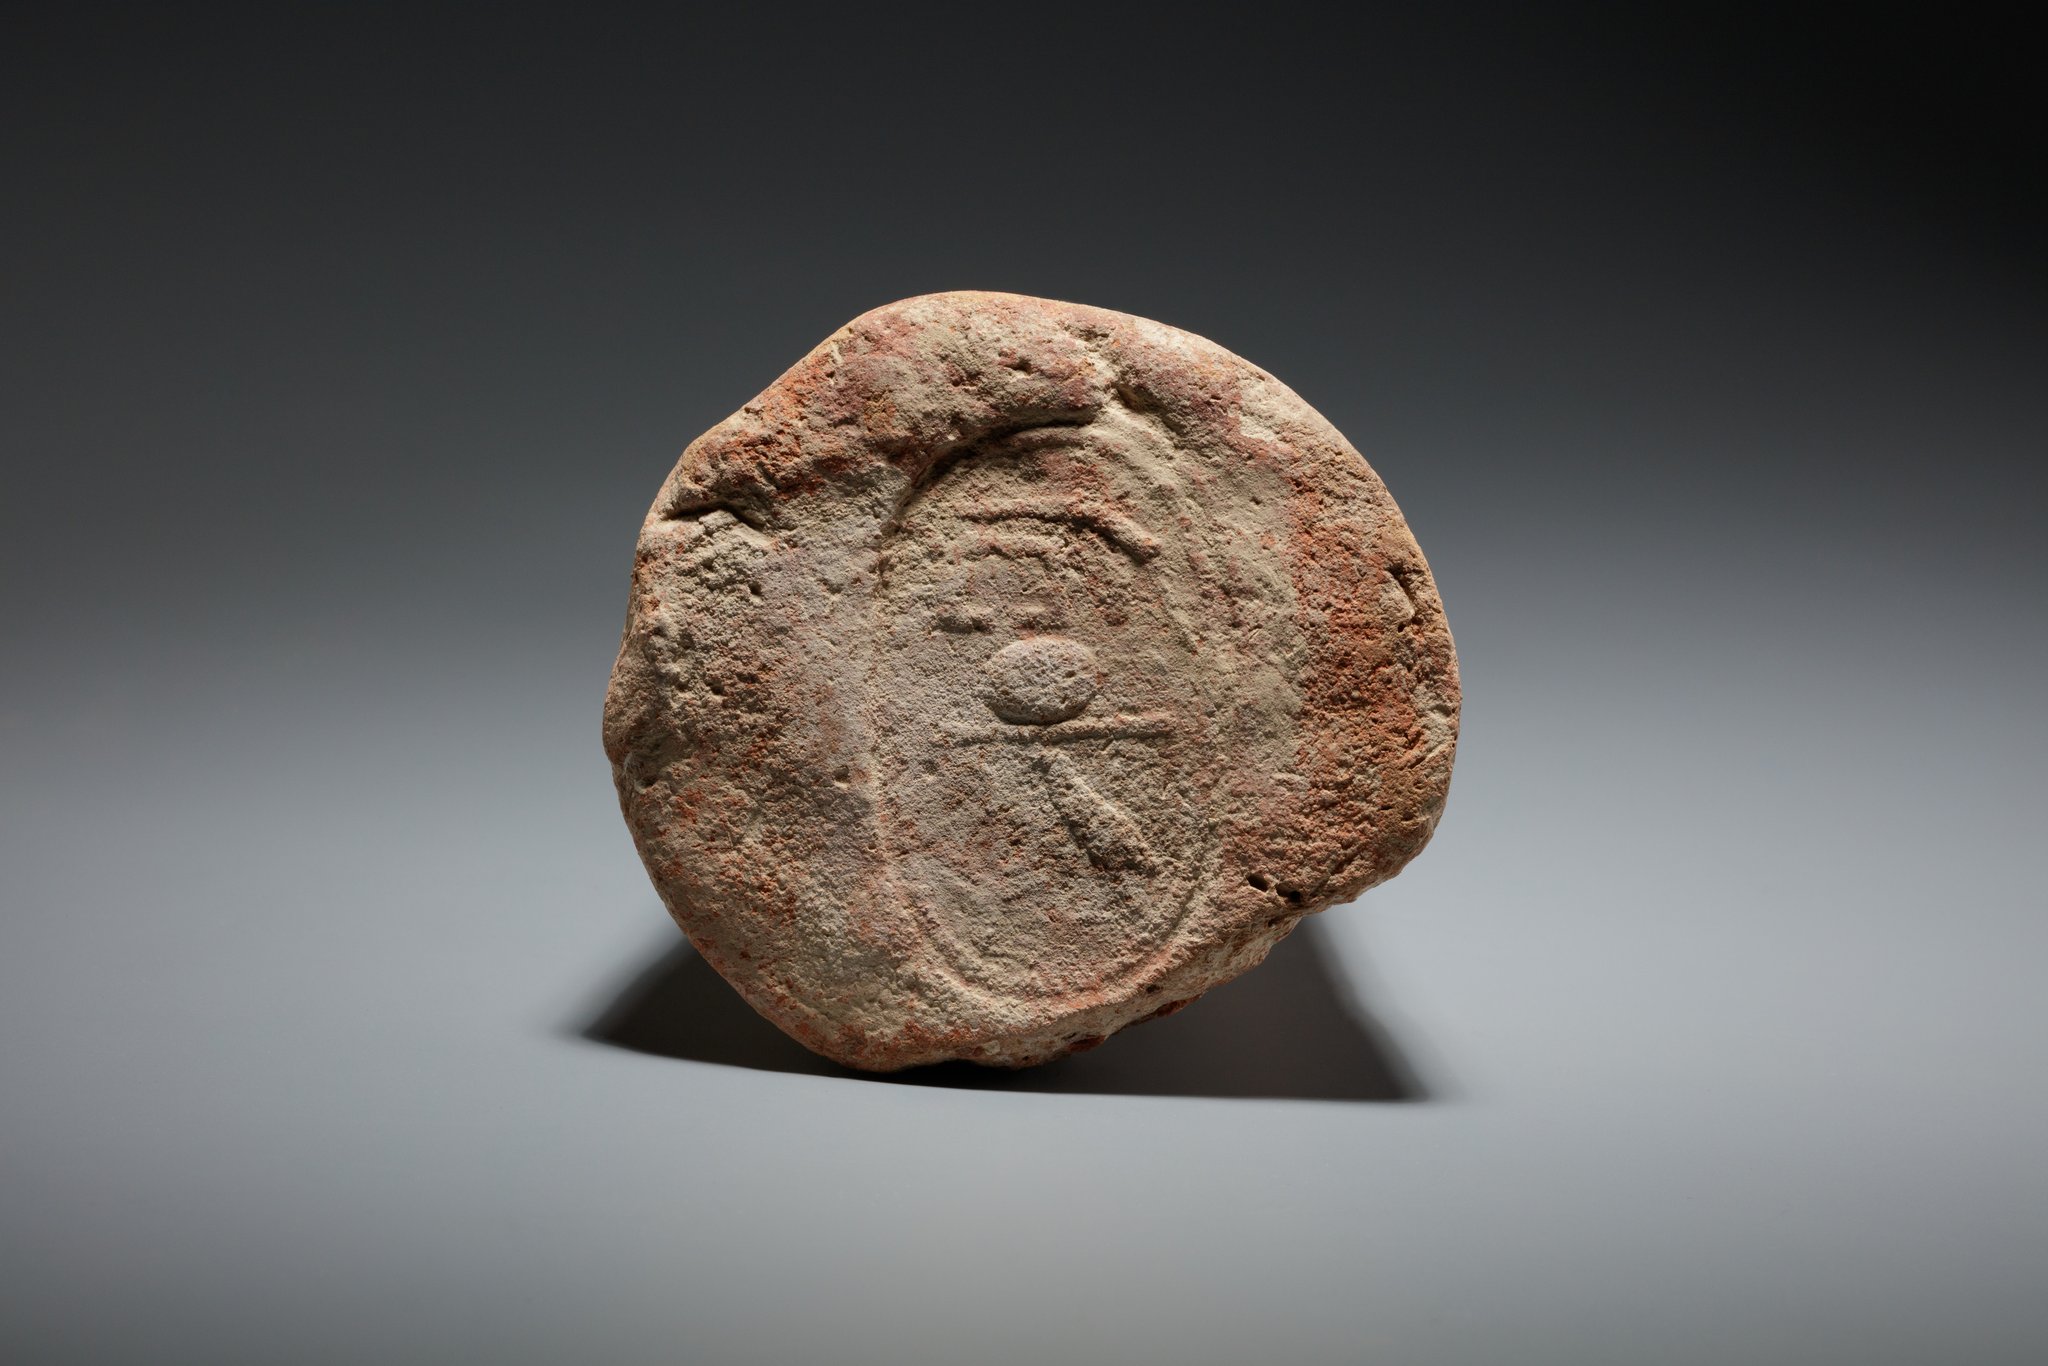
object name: cone, davy 332, khonsu, steward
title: Funerary Cone of the Steward Khonsu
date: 1550-1295 BCE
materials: pottery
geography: egypt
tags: cartouches,hieroglyphs